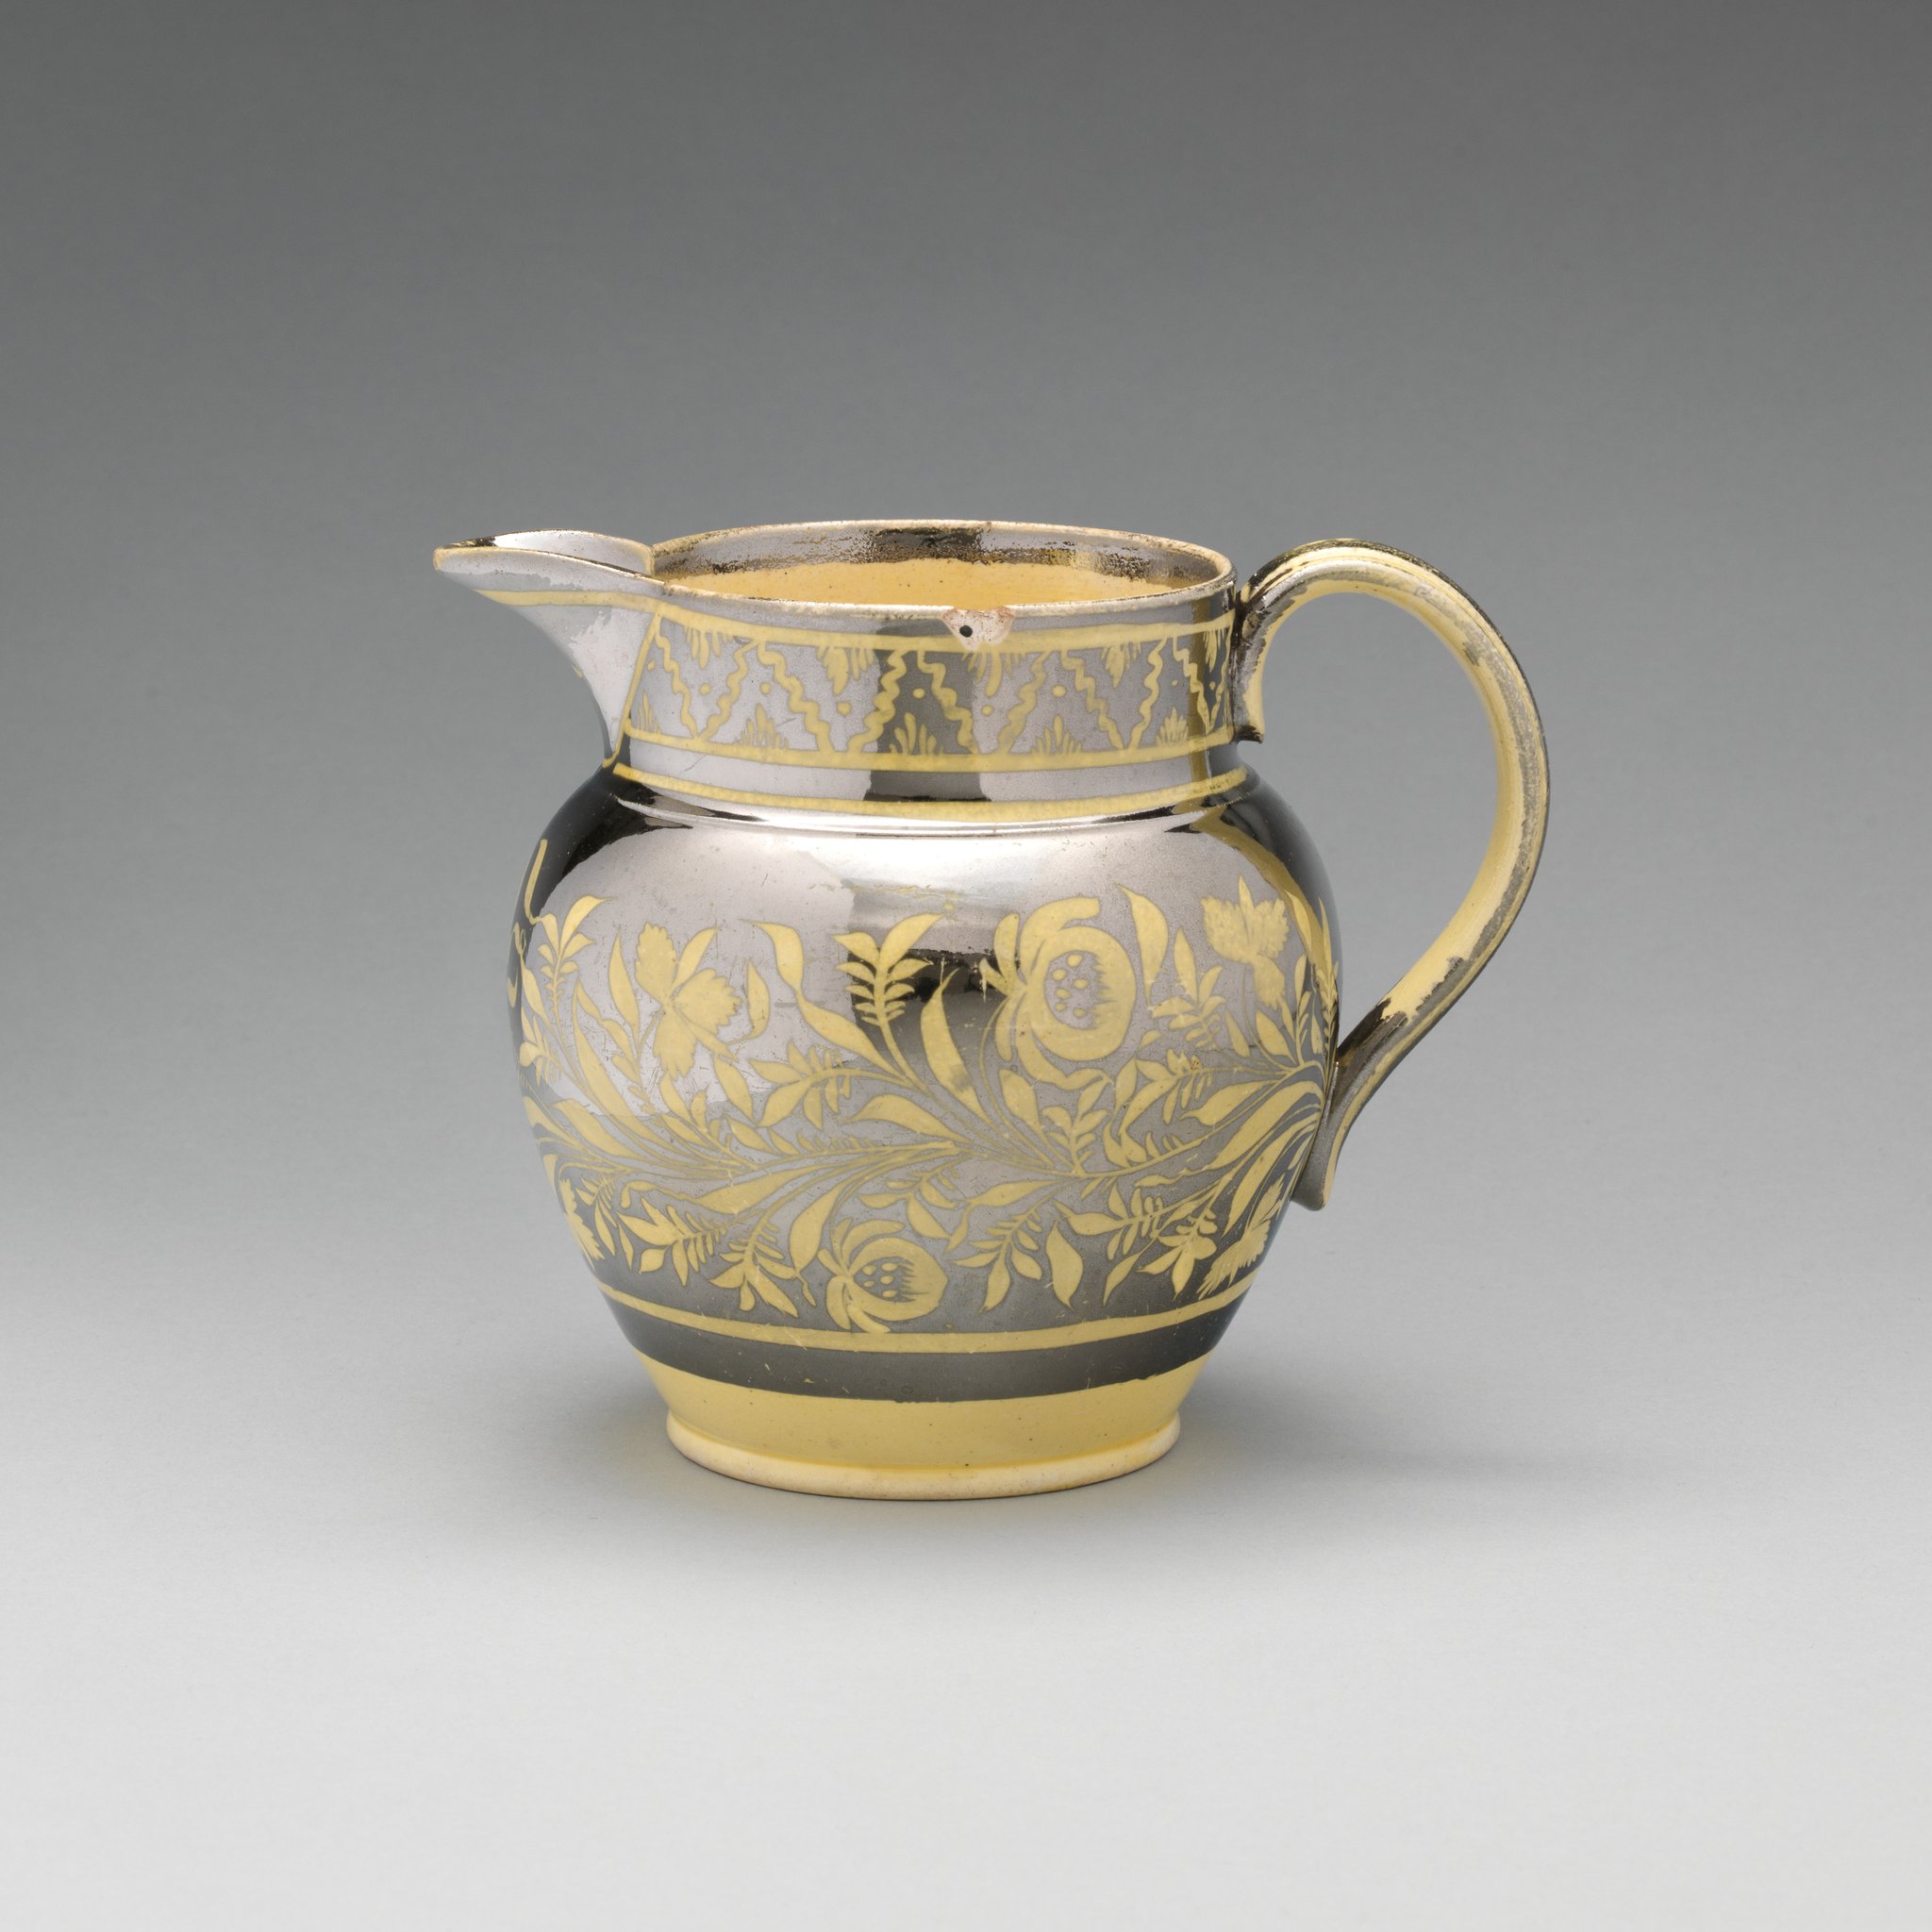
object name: jug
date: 1801-1833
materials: pottery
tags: flowers